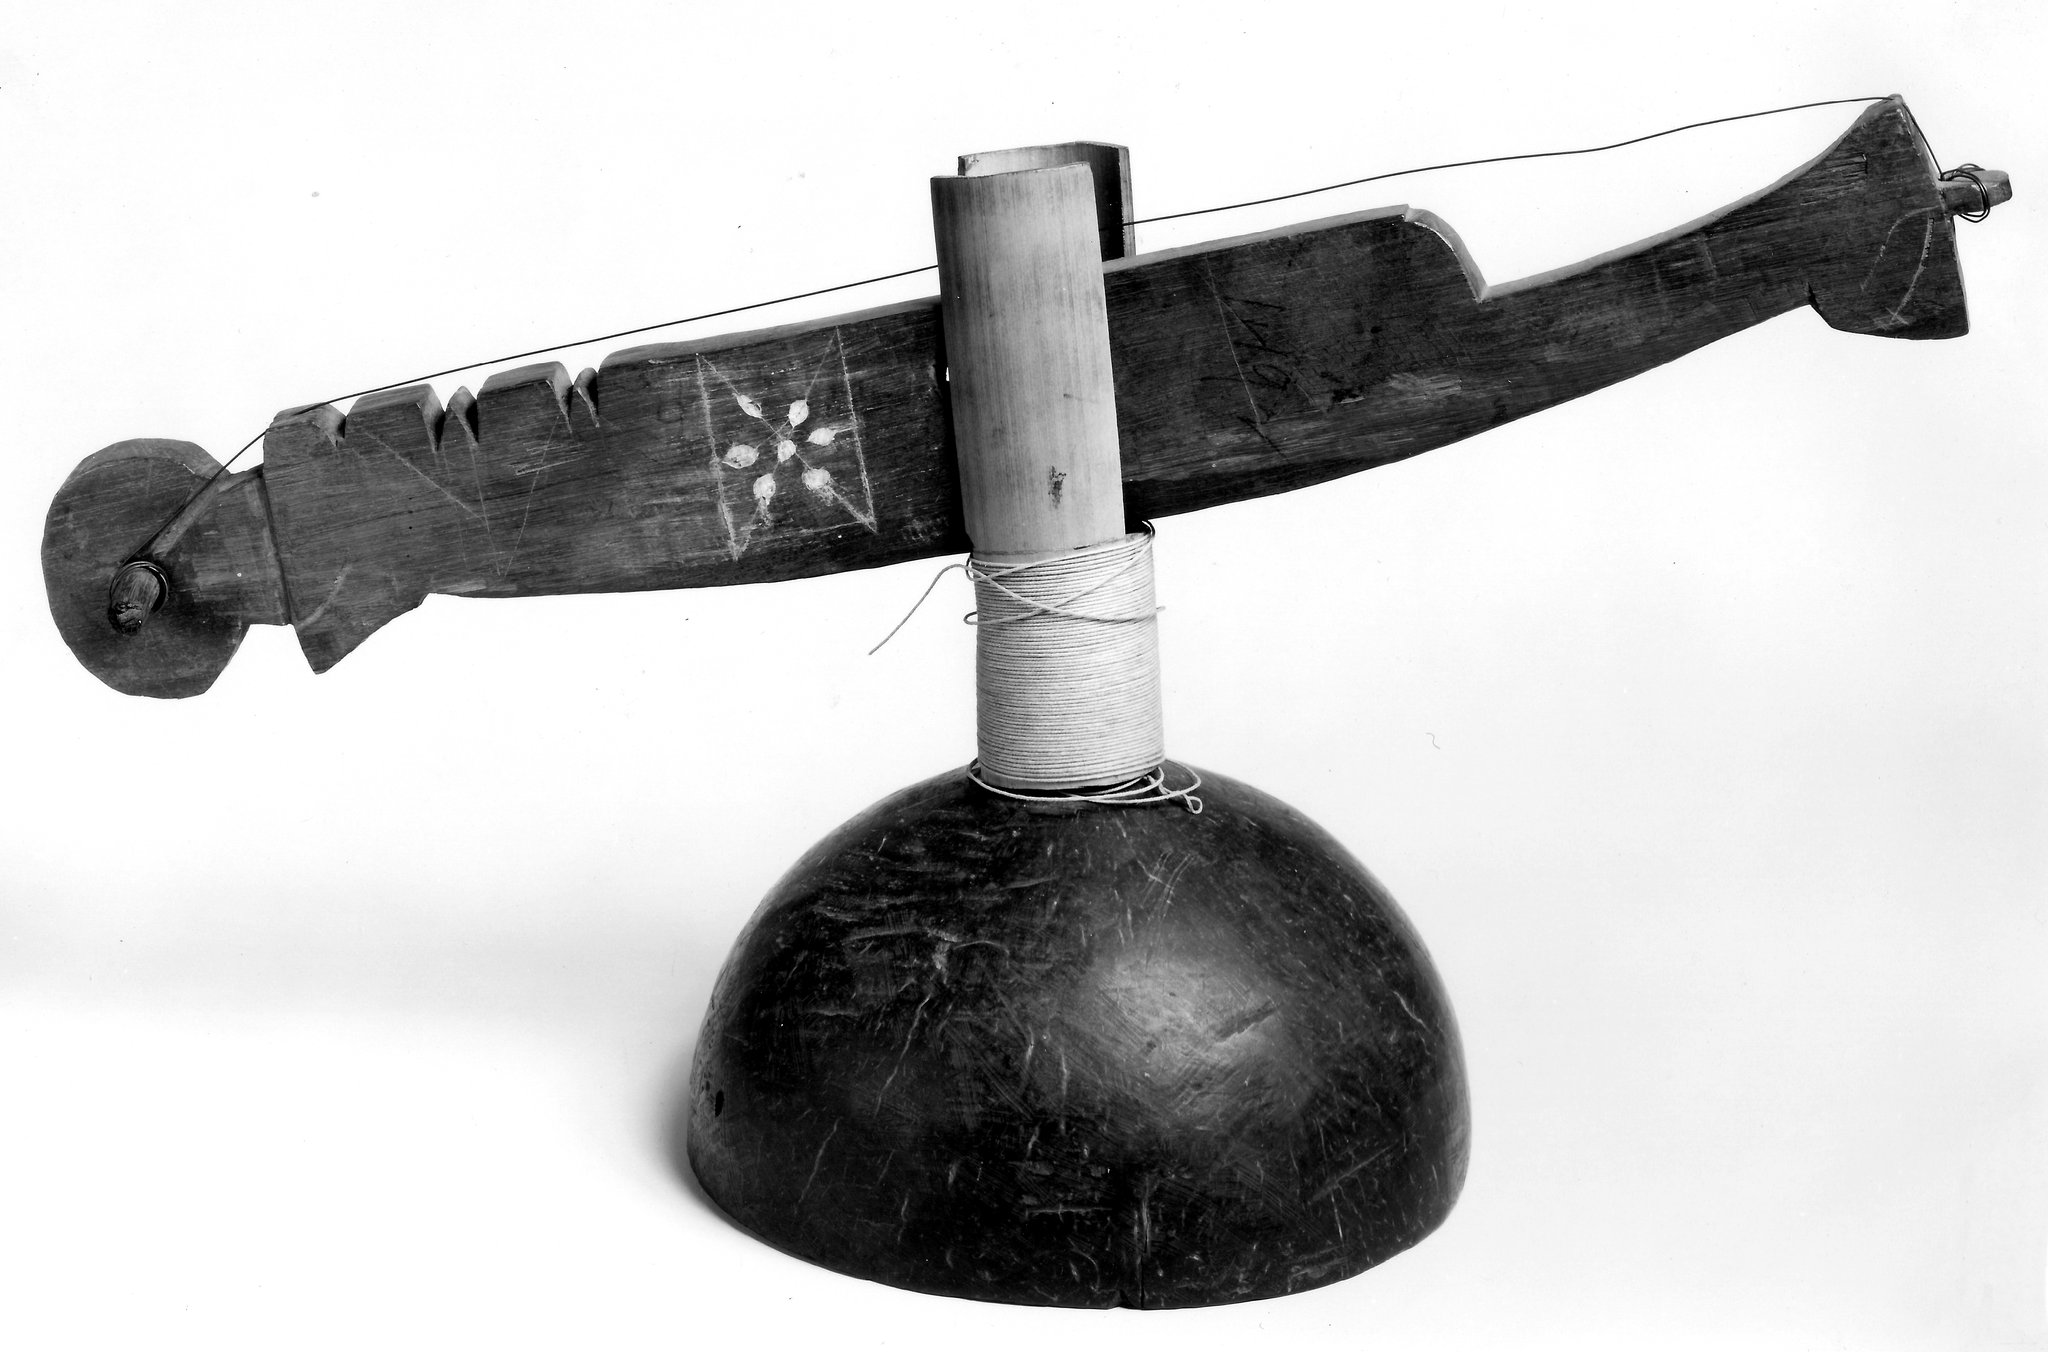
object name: stringed instrument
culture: malagasy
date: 1867-1900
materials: bamboo, plant material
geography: madagascar